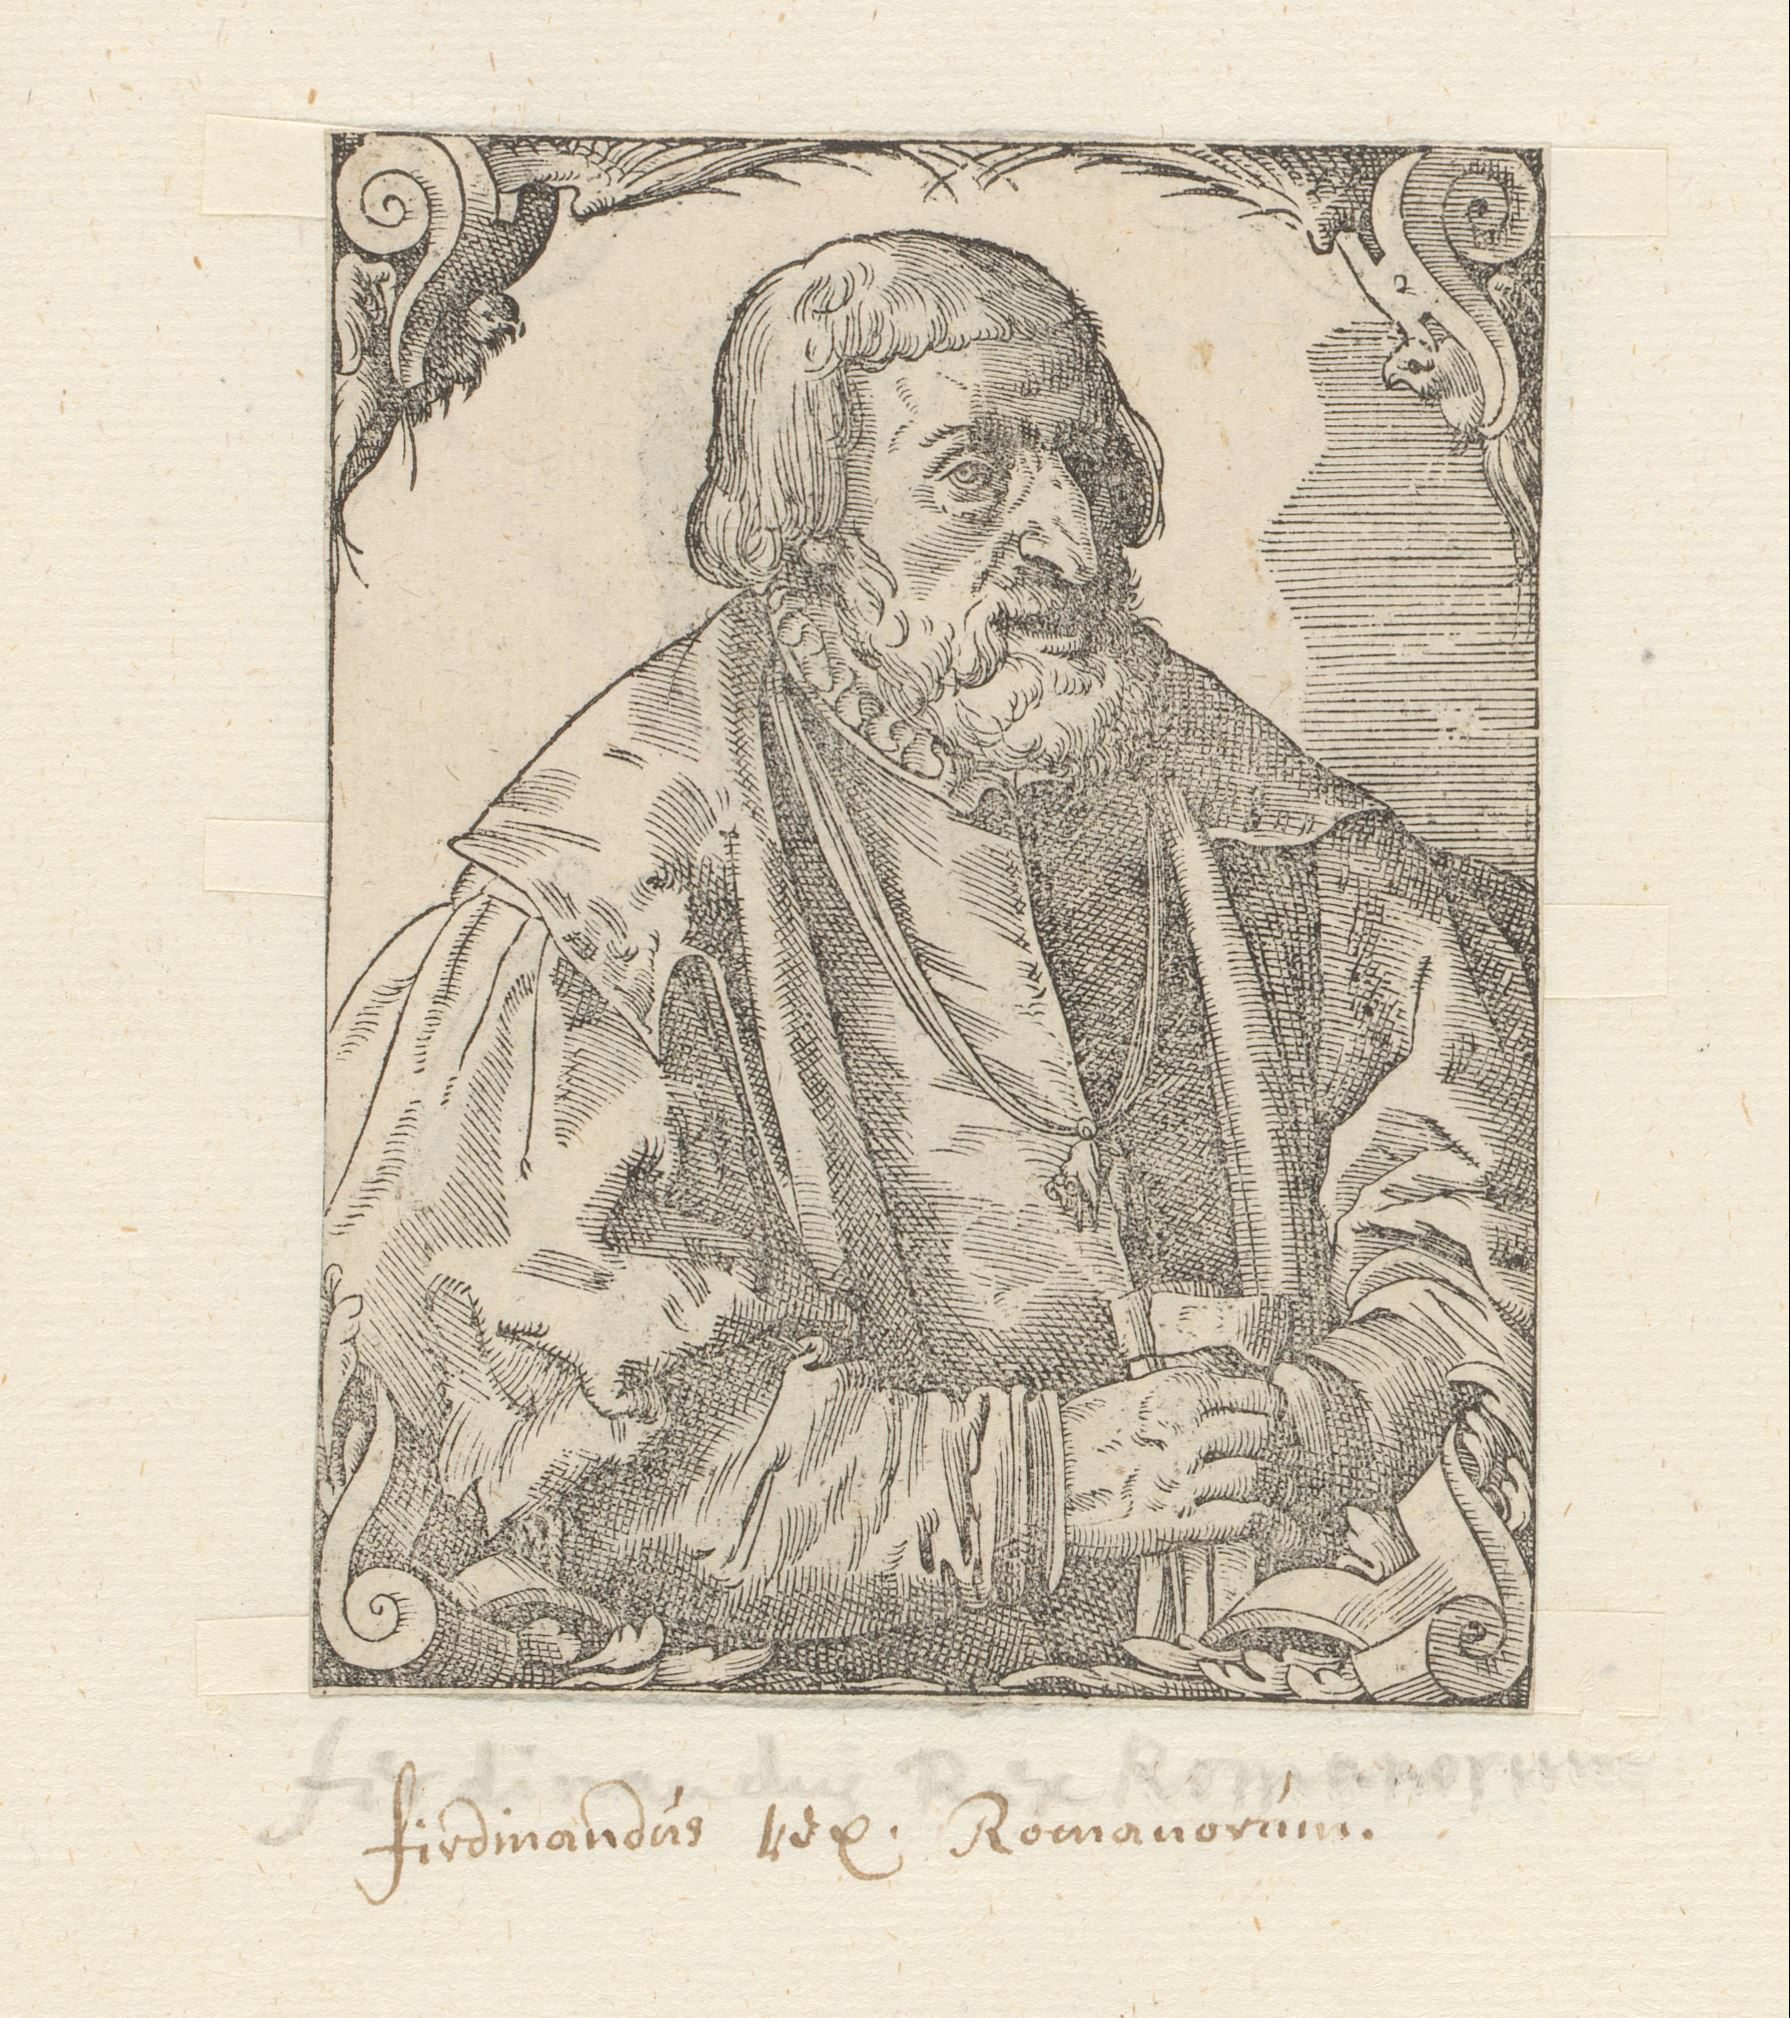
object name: book illustration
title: Portret van keizer Ferdinand I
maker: Anonymous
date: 1549-1575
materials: paper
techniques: woodcut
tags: vienna, ferdinand i van habsburg (duits keizer), historical persons, ruler, sovereign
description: Prent gebruikt in: Giovio, Paolo. Elogia Virorum bellica virtute illustrium (...). Bazel: Peter Perna, 1575.